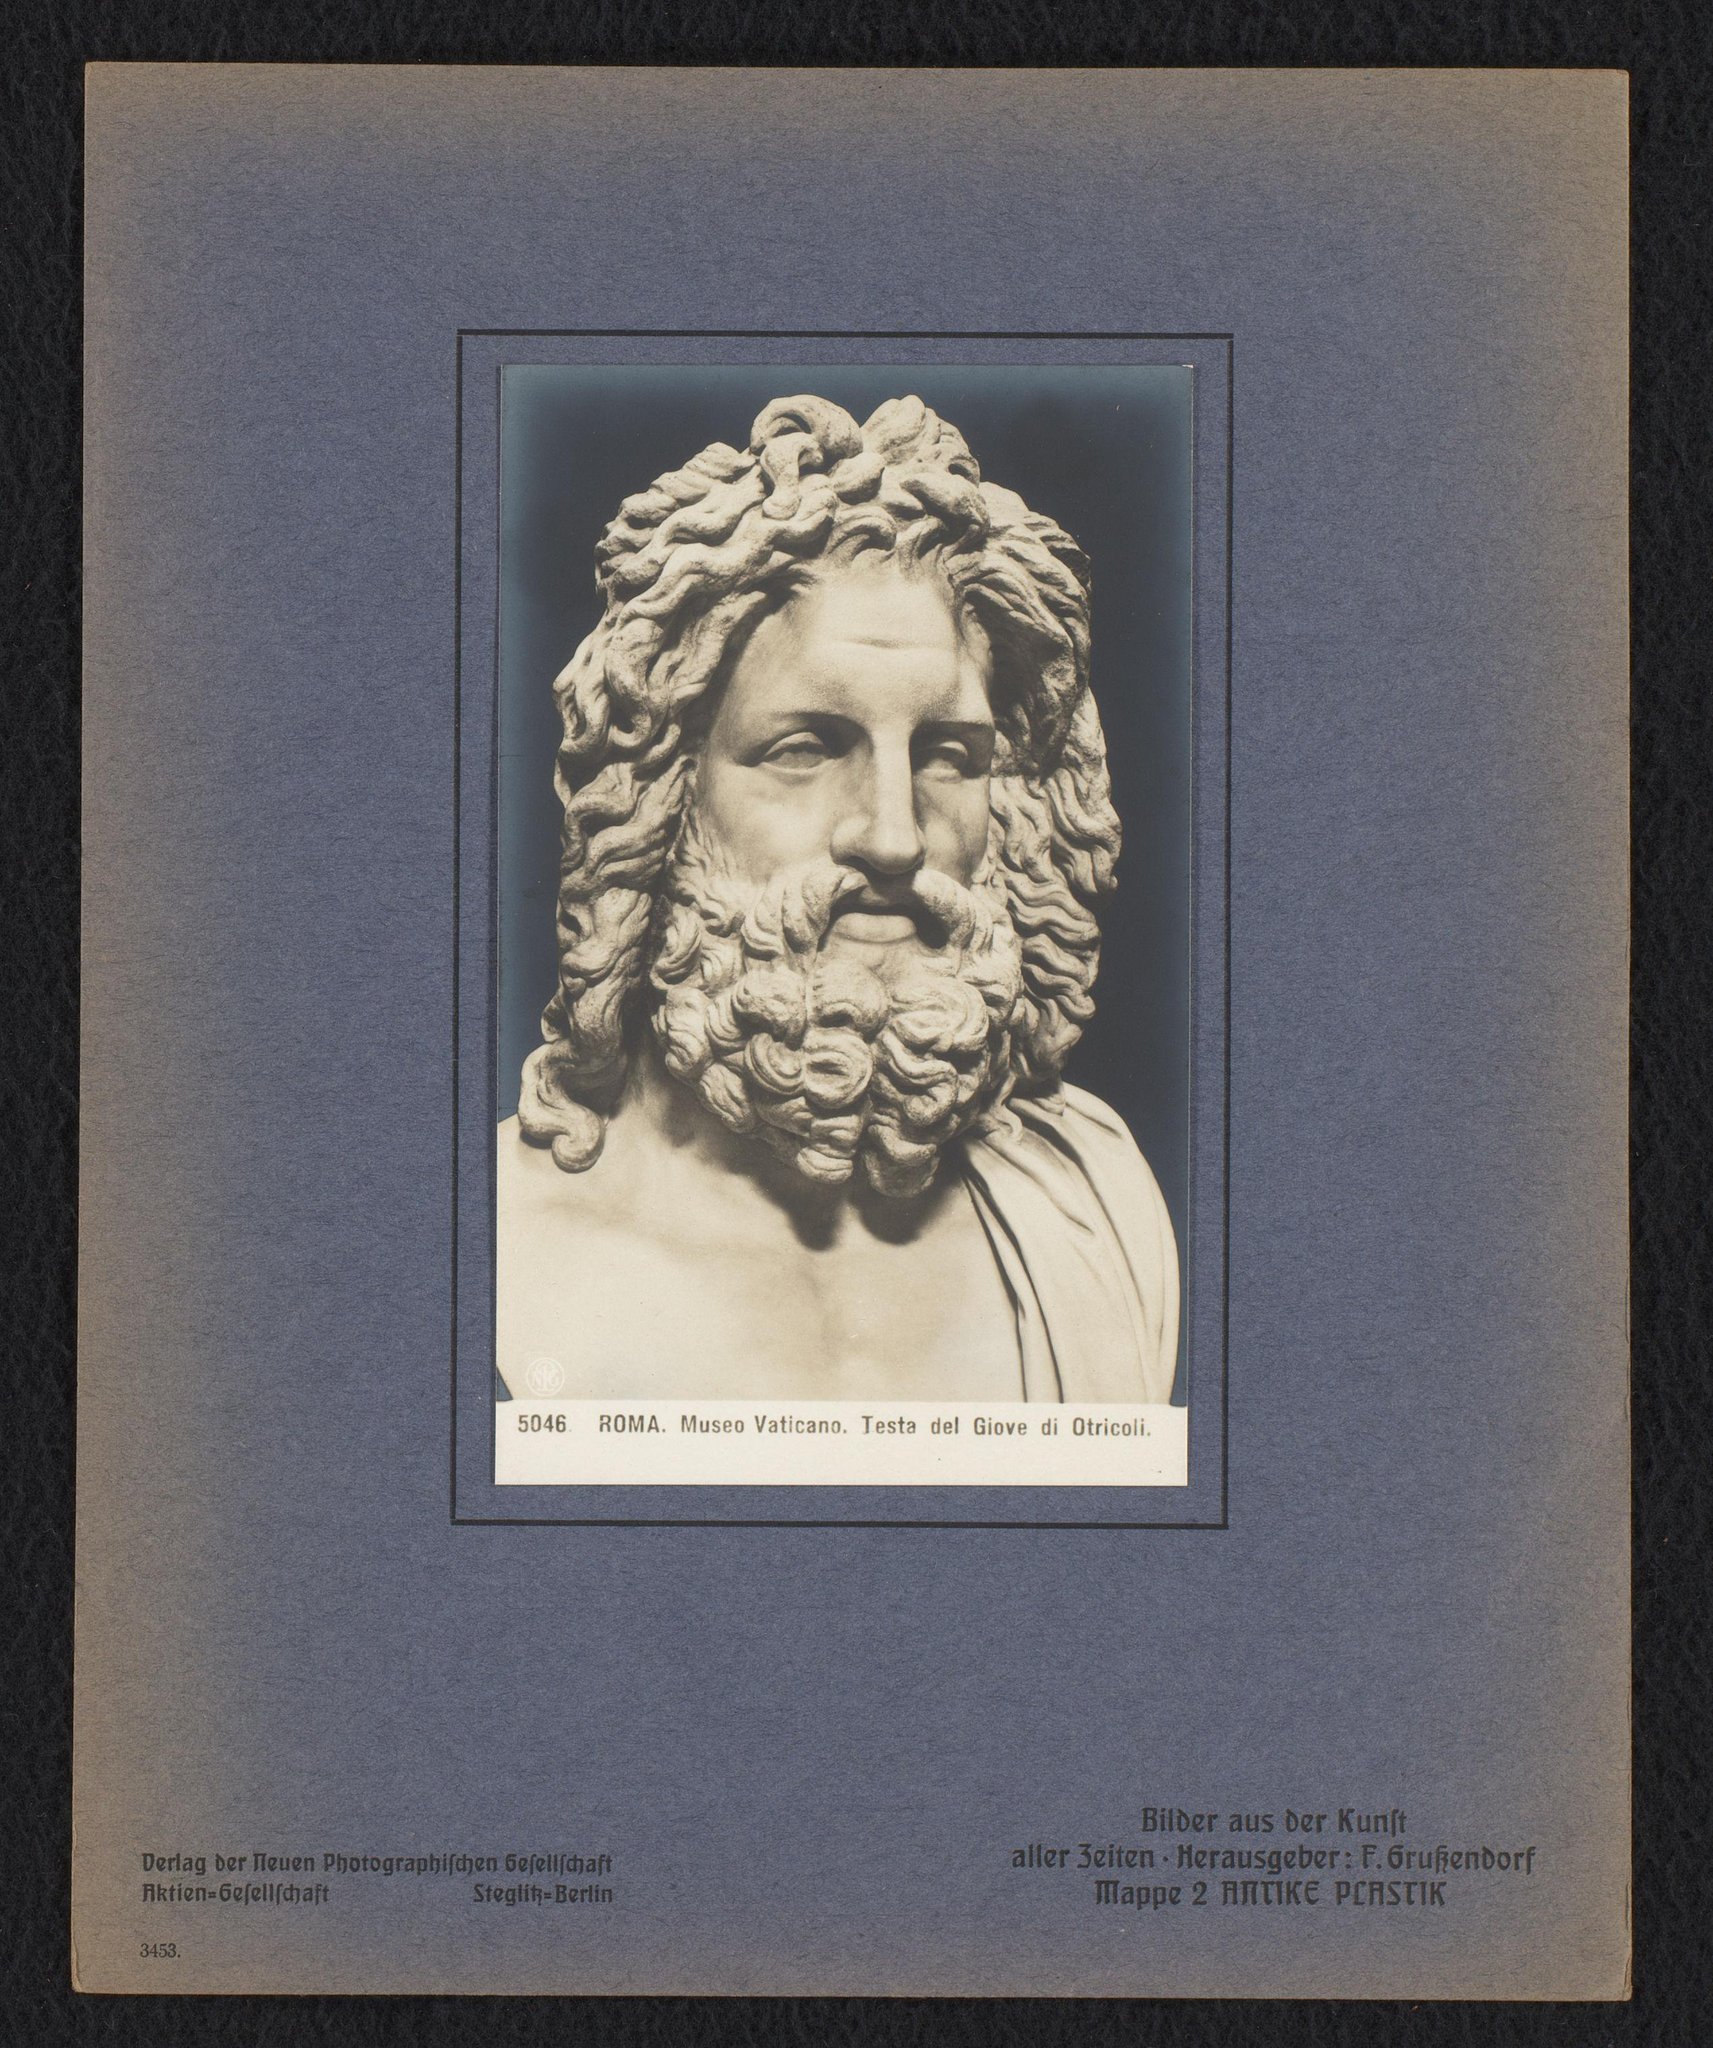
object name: photograph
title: Roma, Museo Vaticano, Testa del Giove Otricoli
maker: Anonymous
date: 1906-1911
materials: paper, cardboard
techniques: gelatin silver print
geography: steglitz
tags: sculpture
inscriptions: number: ‘5046.’